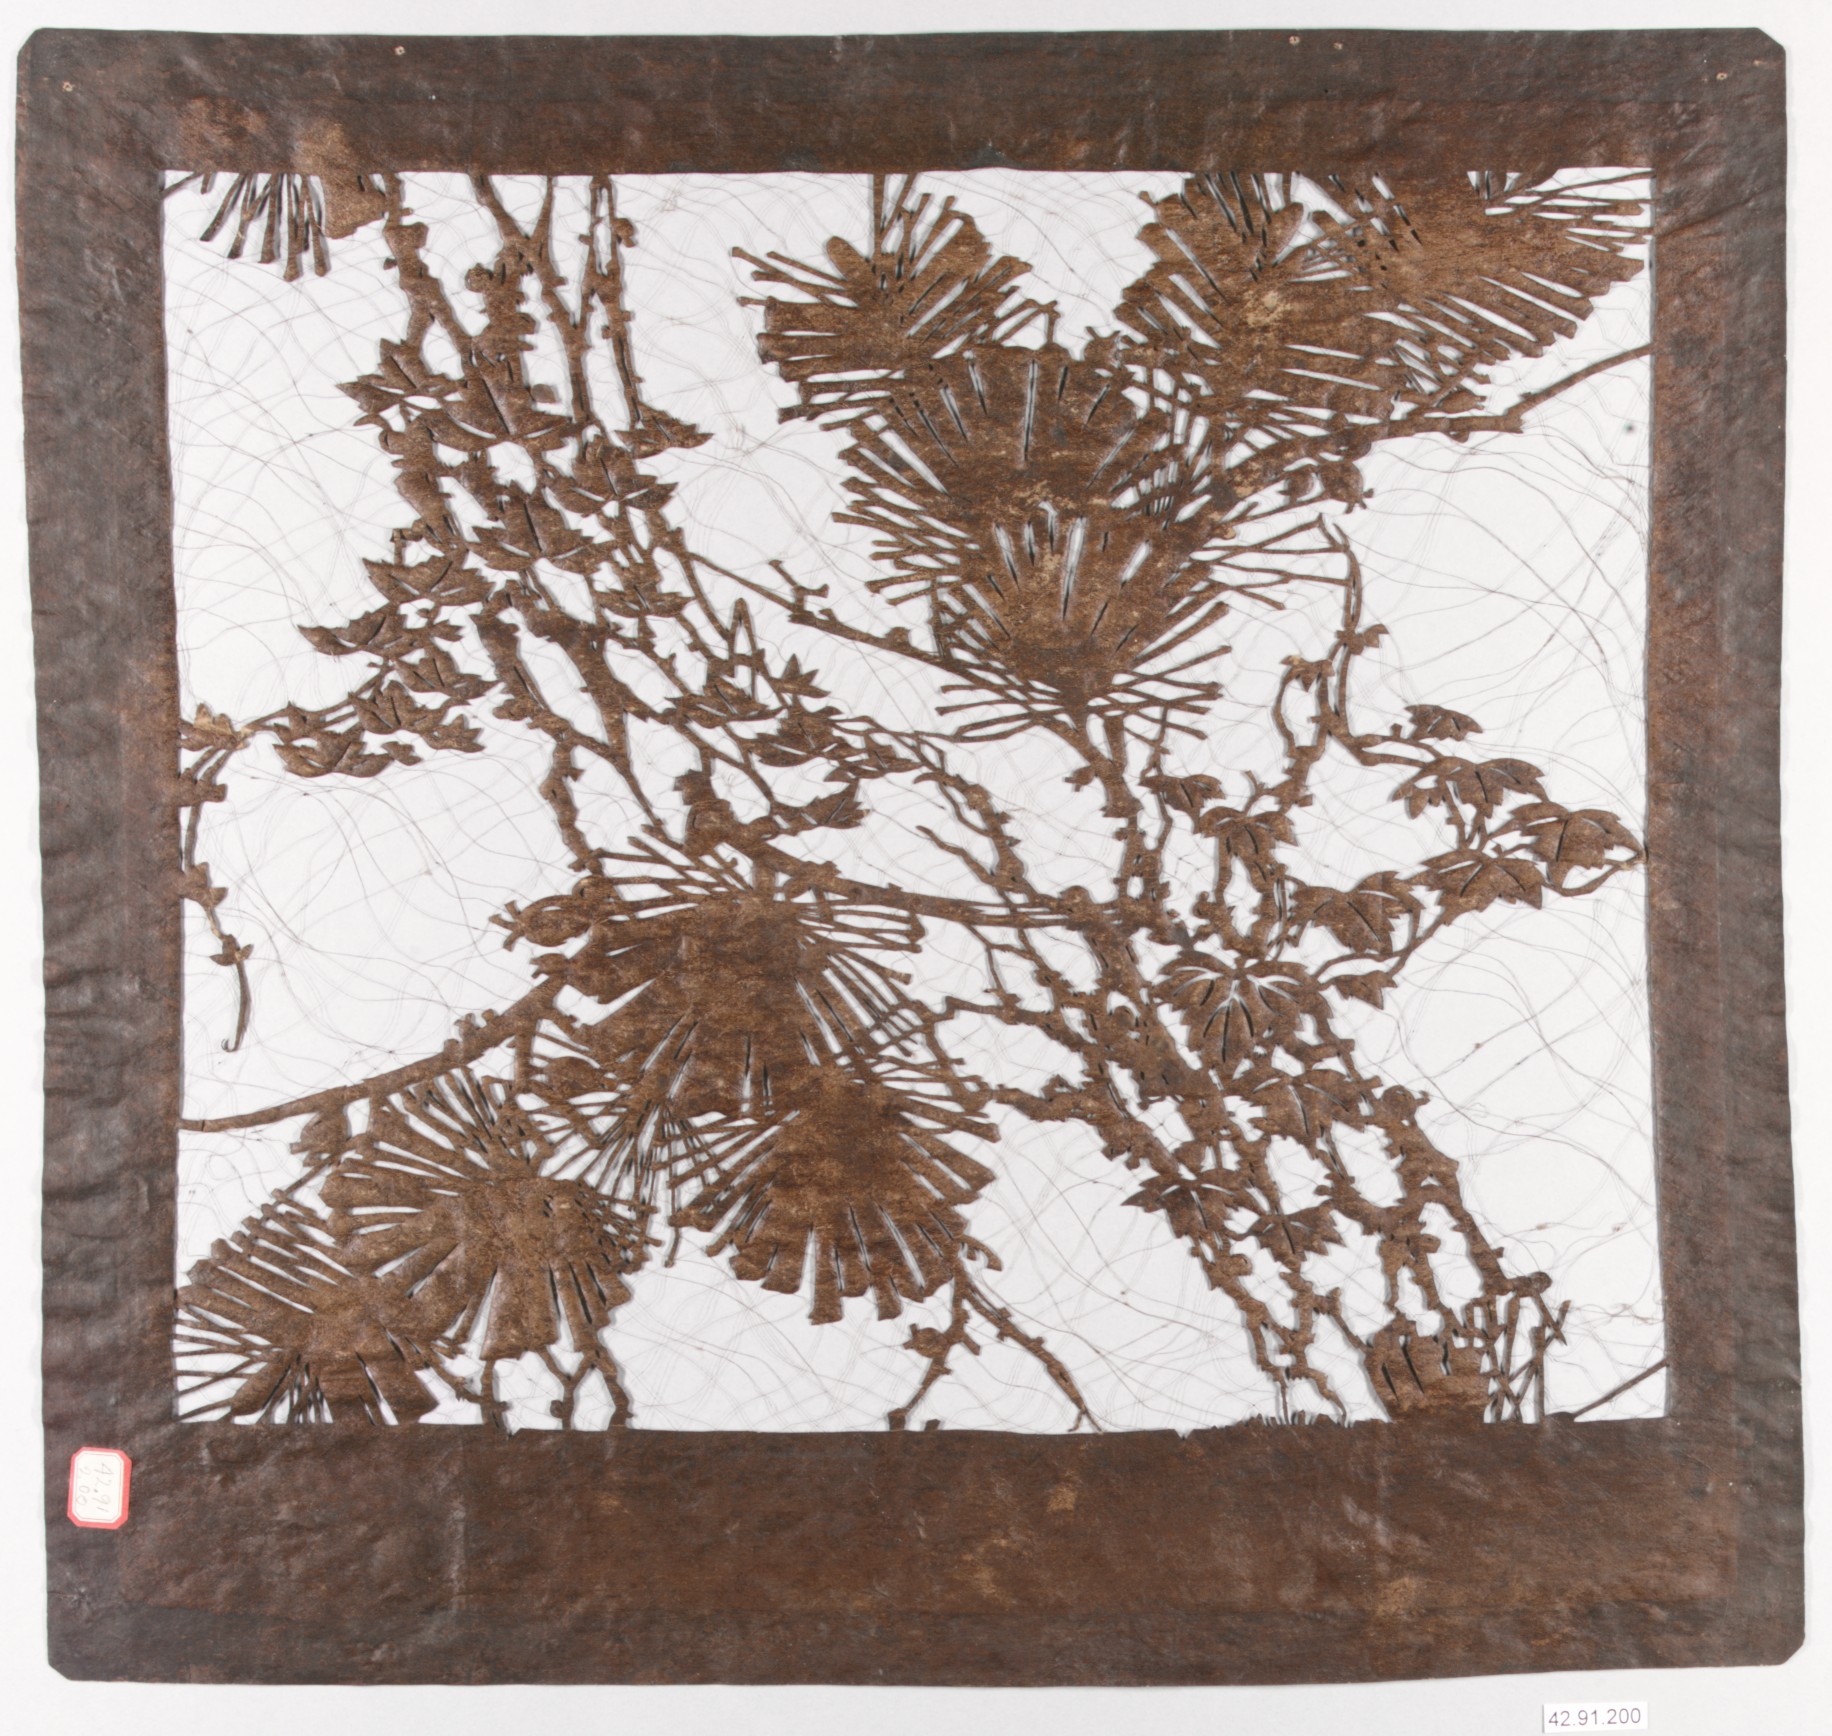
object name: stencil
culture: japanese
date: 1801-1900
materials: paper, silk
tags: leaves